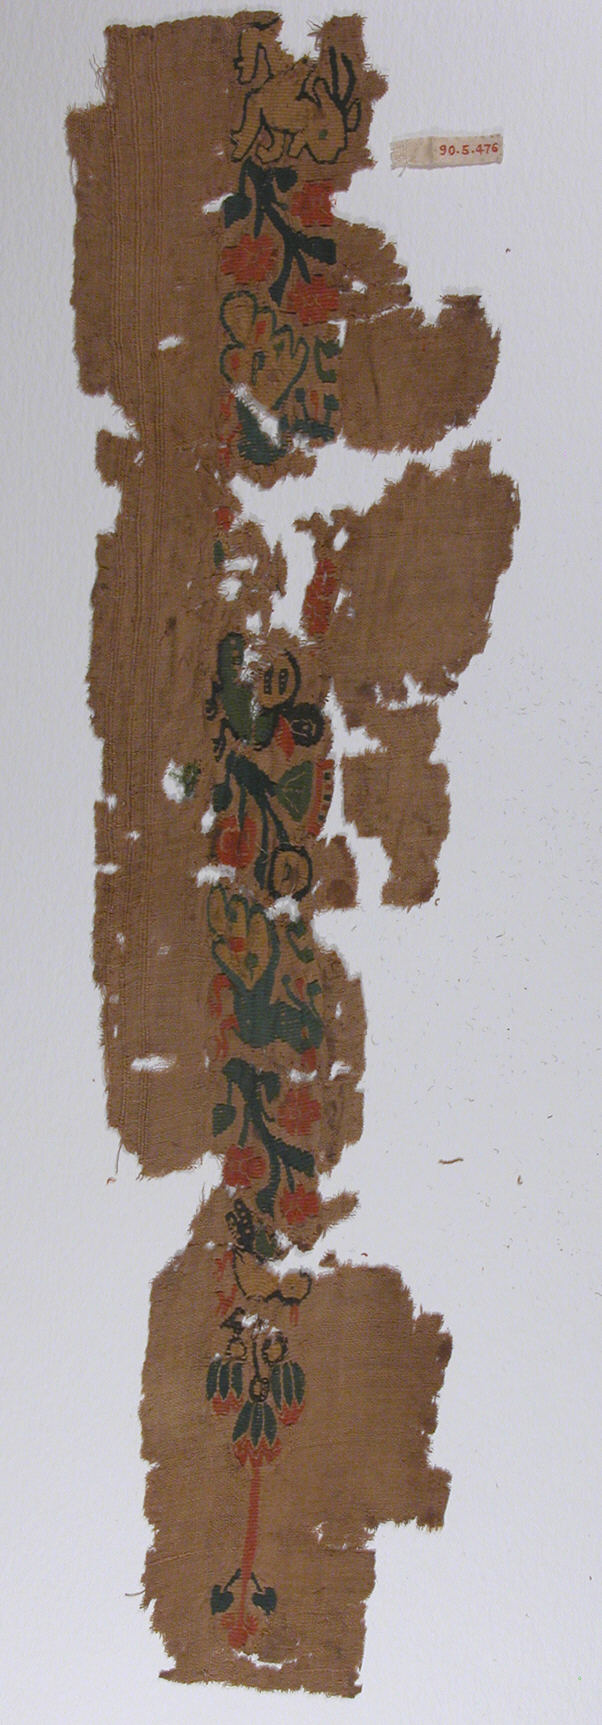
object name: textile fragment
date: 301-500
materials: linen, wool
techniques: weave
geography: egypt